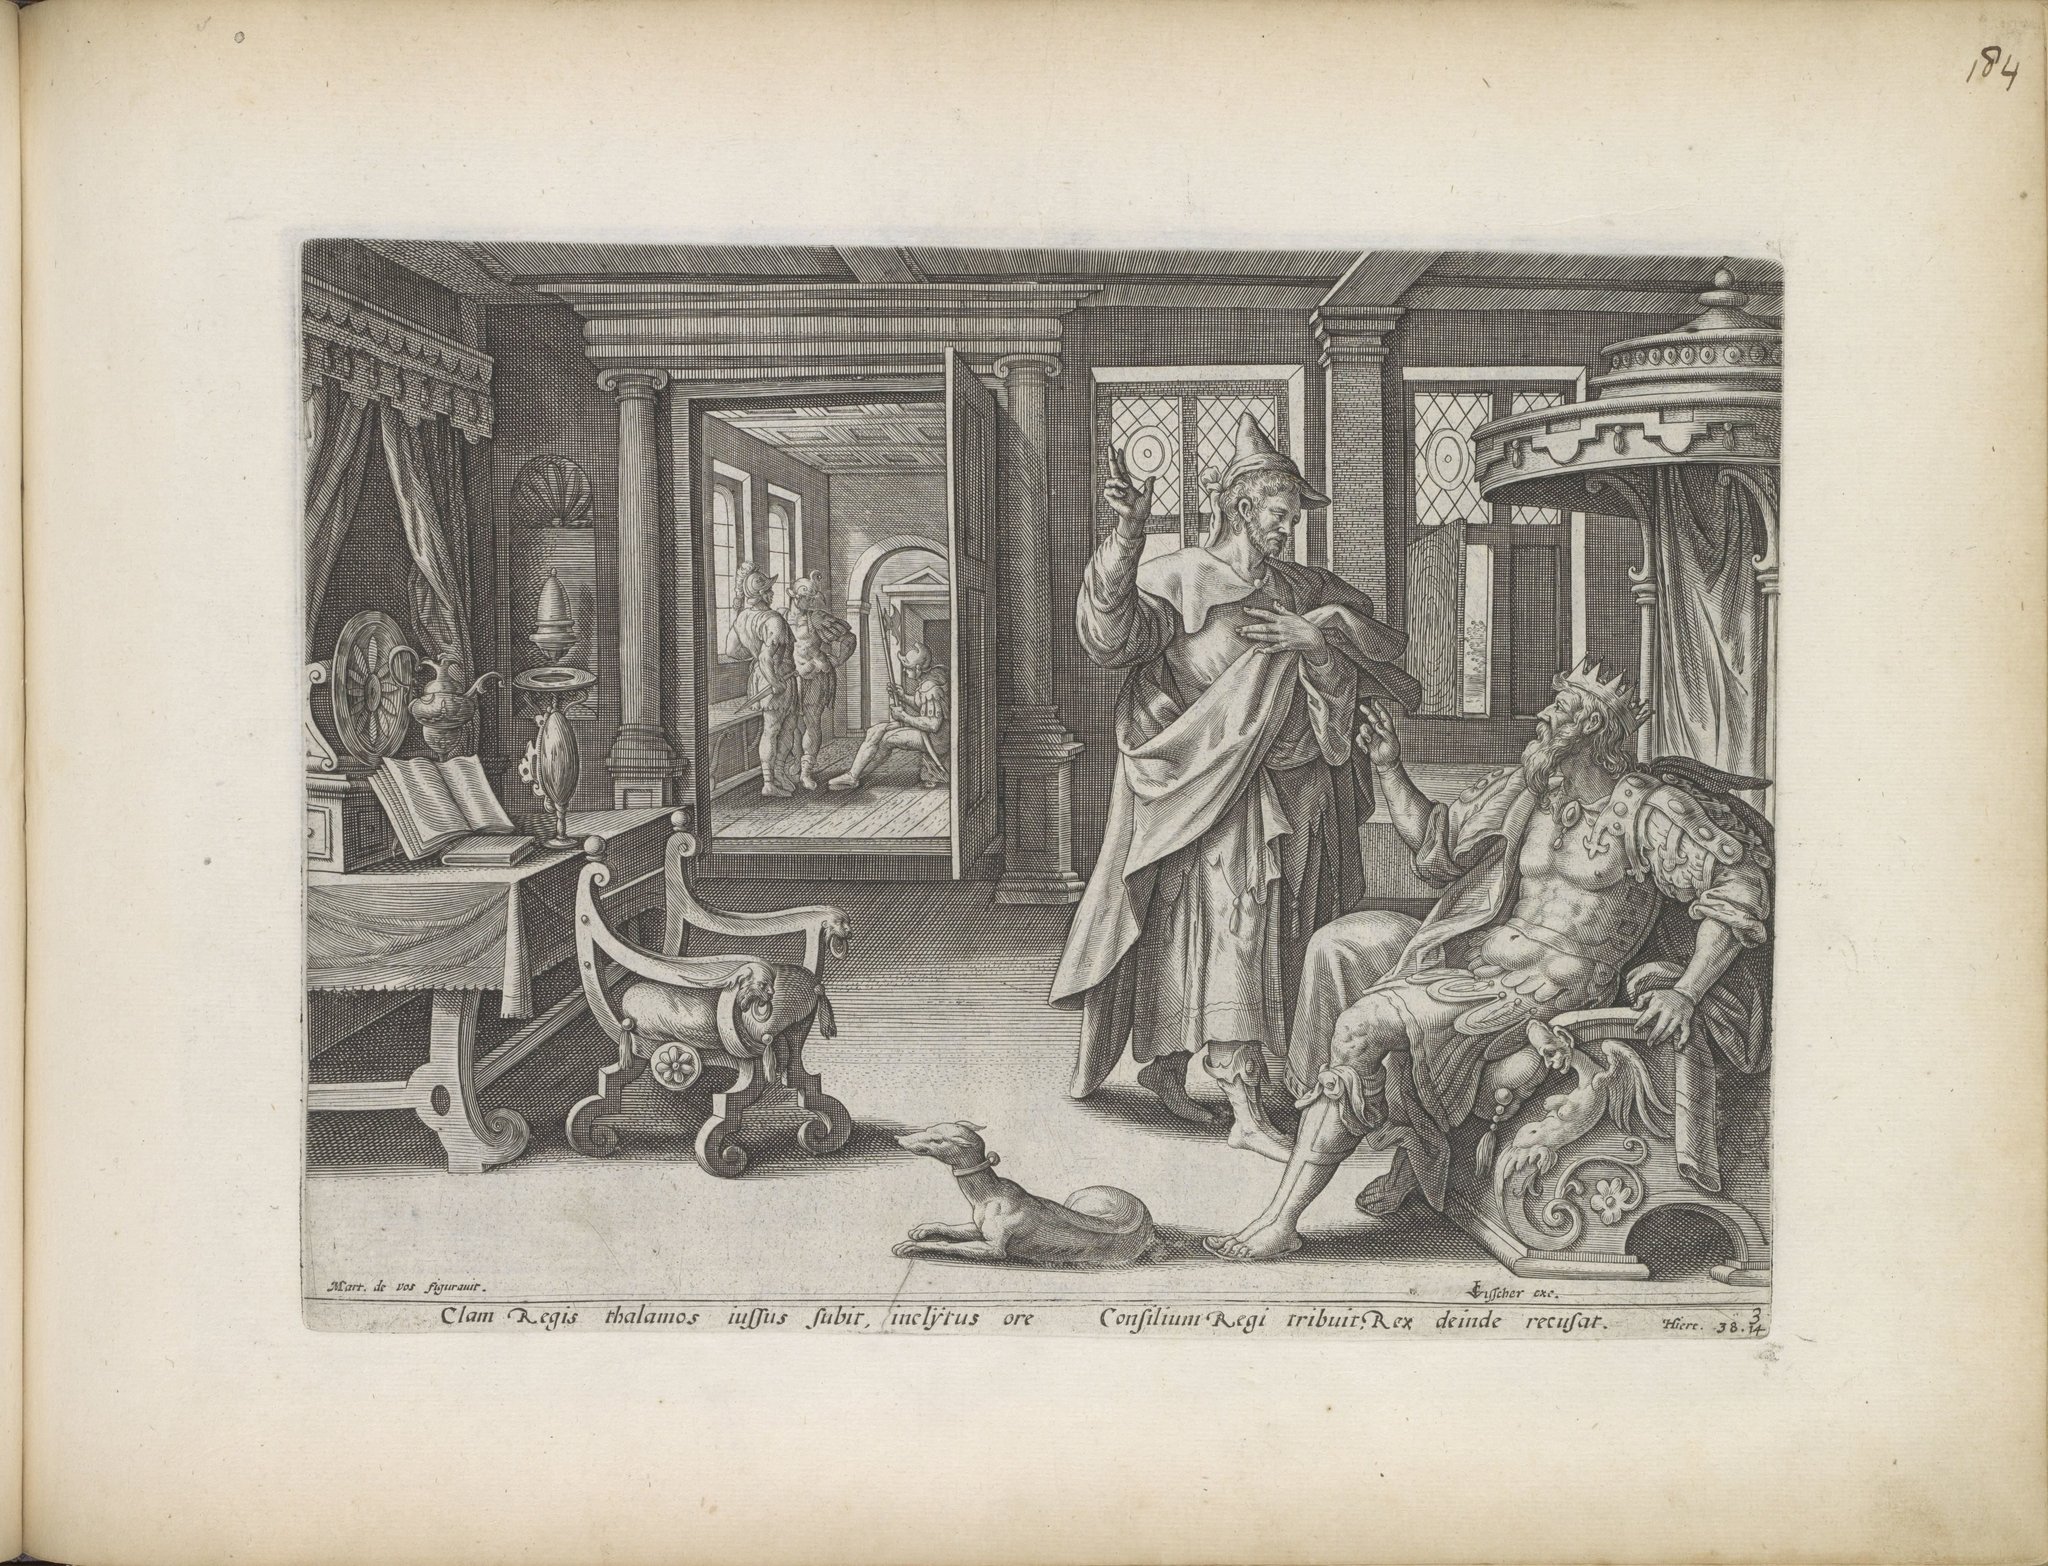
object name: print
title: Jeremia bij koning Sedekia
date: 1585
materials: paper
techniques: engraving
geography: amsterdam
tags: jeremiah before zedekiah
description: Koning Sedekia vraagt aan Jeremia wat God aan hem heeft geopenbaard. Onder de voorstelling een verwijzing in het Latijn naar de Bijbeltekst in Jer. 38:14. Deze prent maakt deel uit van een album.